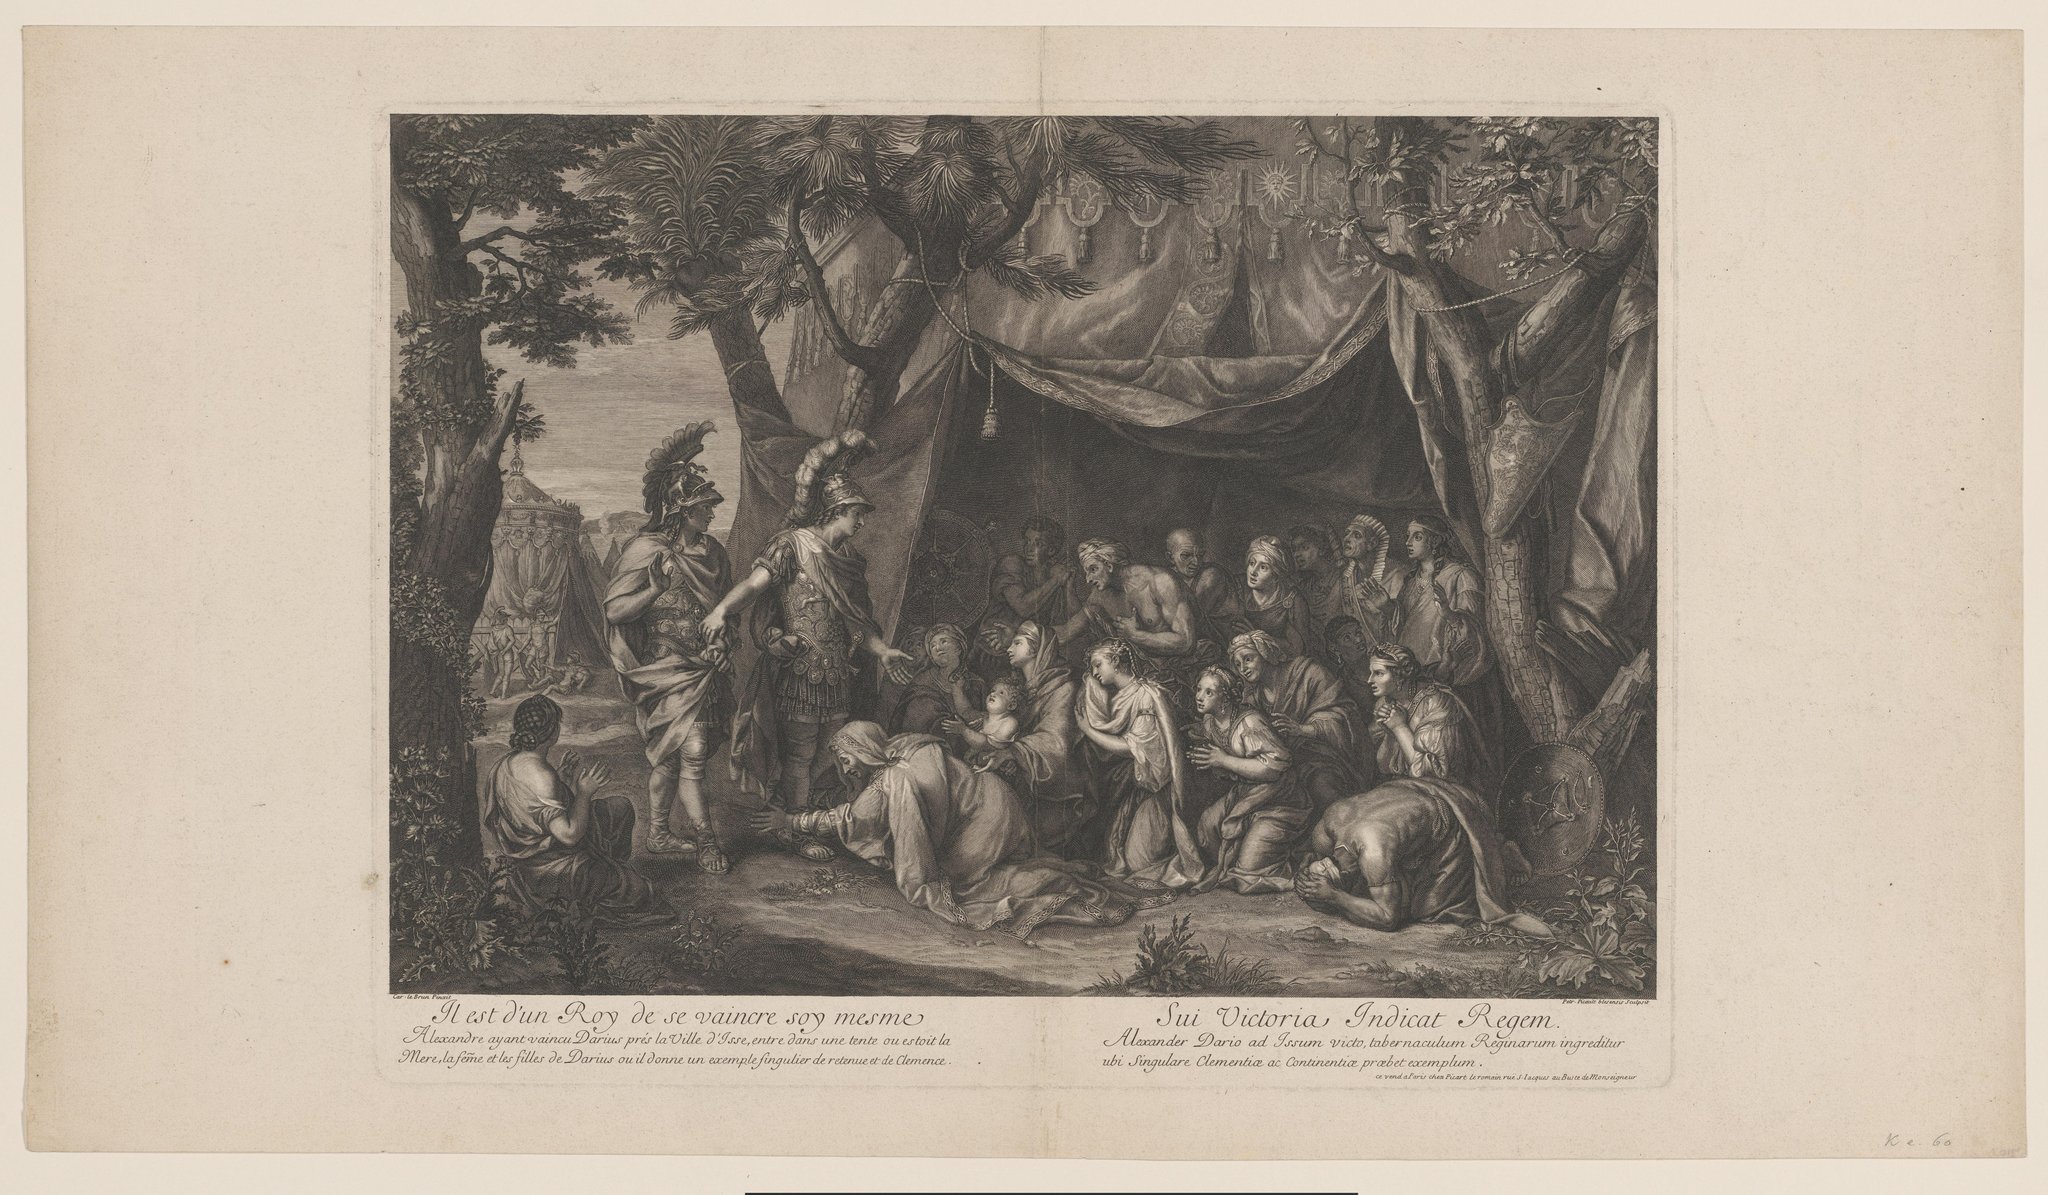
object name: print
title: Alexander de Grote bij de familie van Darius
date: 1690-1711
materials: paper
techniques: engraving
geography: paris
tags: (story of) alexander the great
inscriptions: collector's mark: Lugt 240